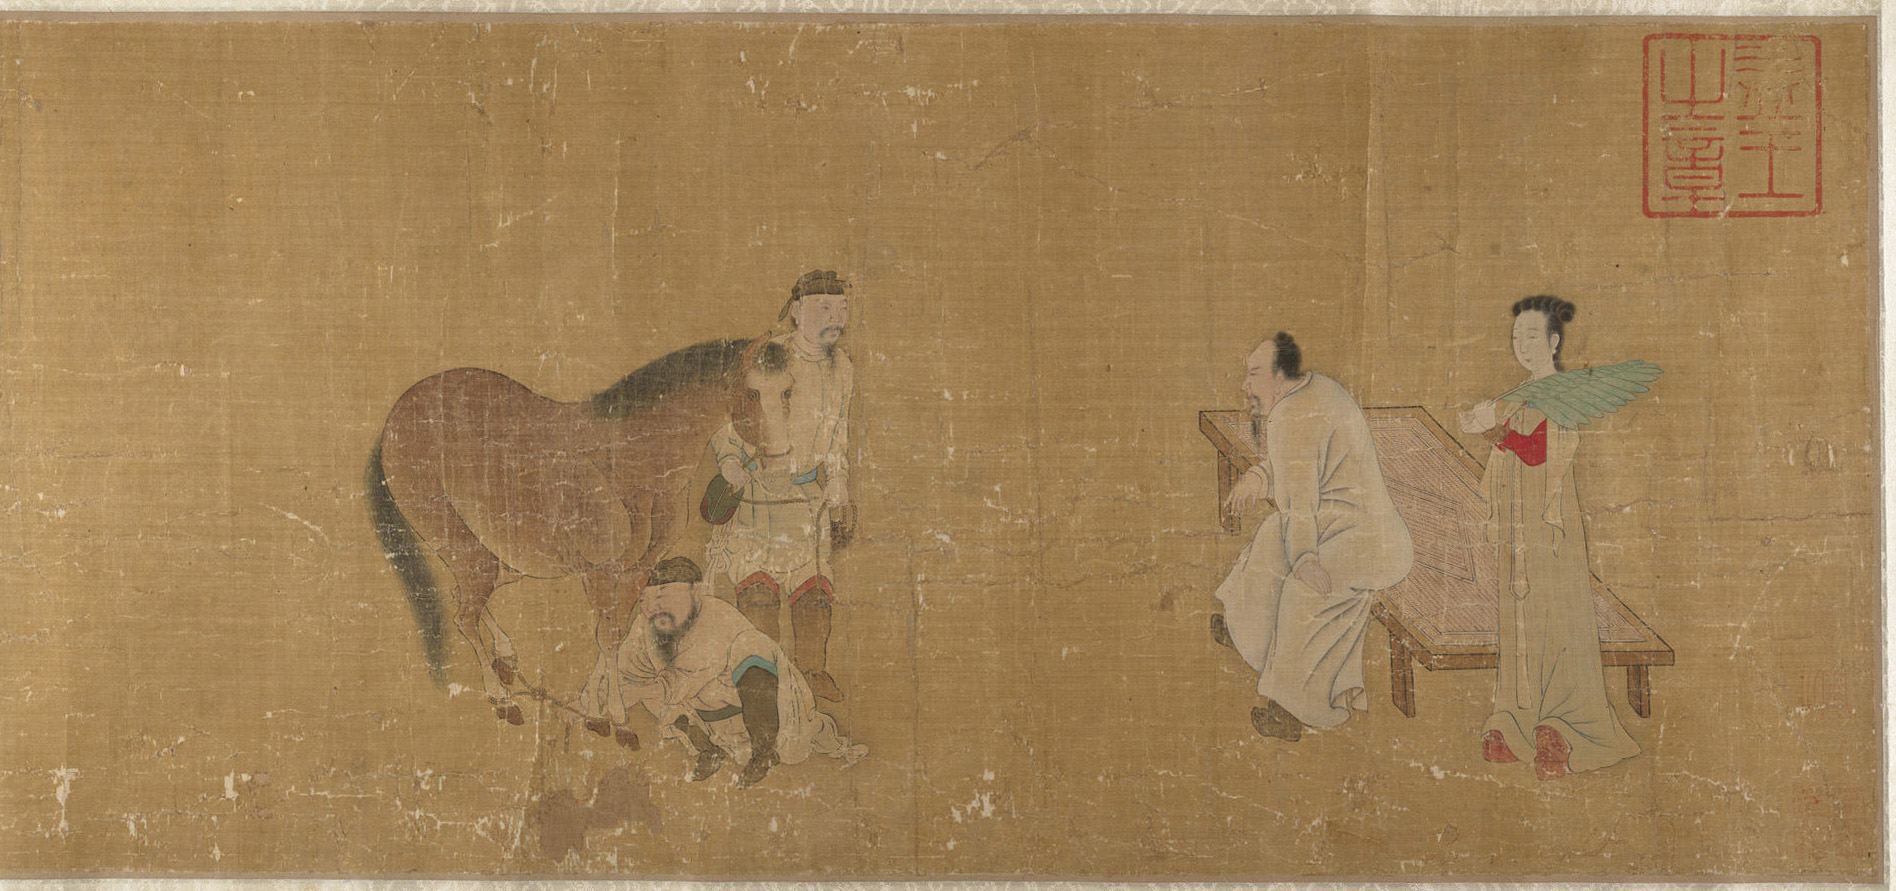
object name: handscroll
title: Judging a Horse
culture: chinese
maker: unidentified artist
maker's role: artist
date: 1368-1911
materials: ink, silk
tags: men,women,horses